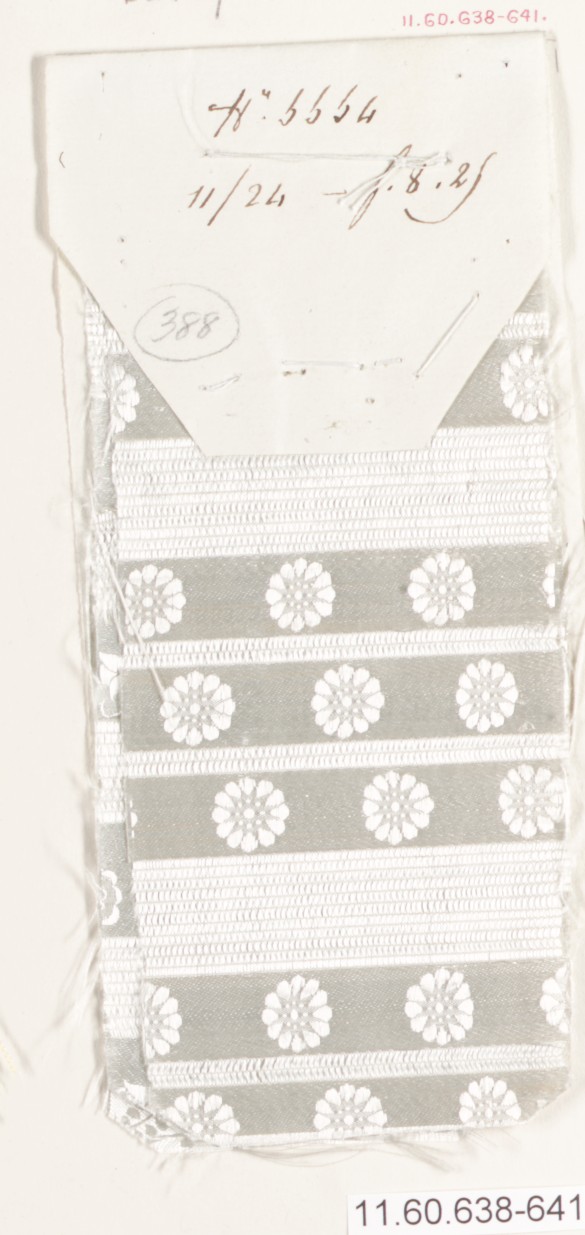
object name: sample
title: Samples (3)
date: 1801-1833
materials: silk